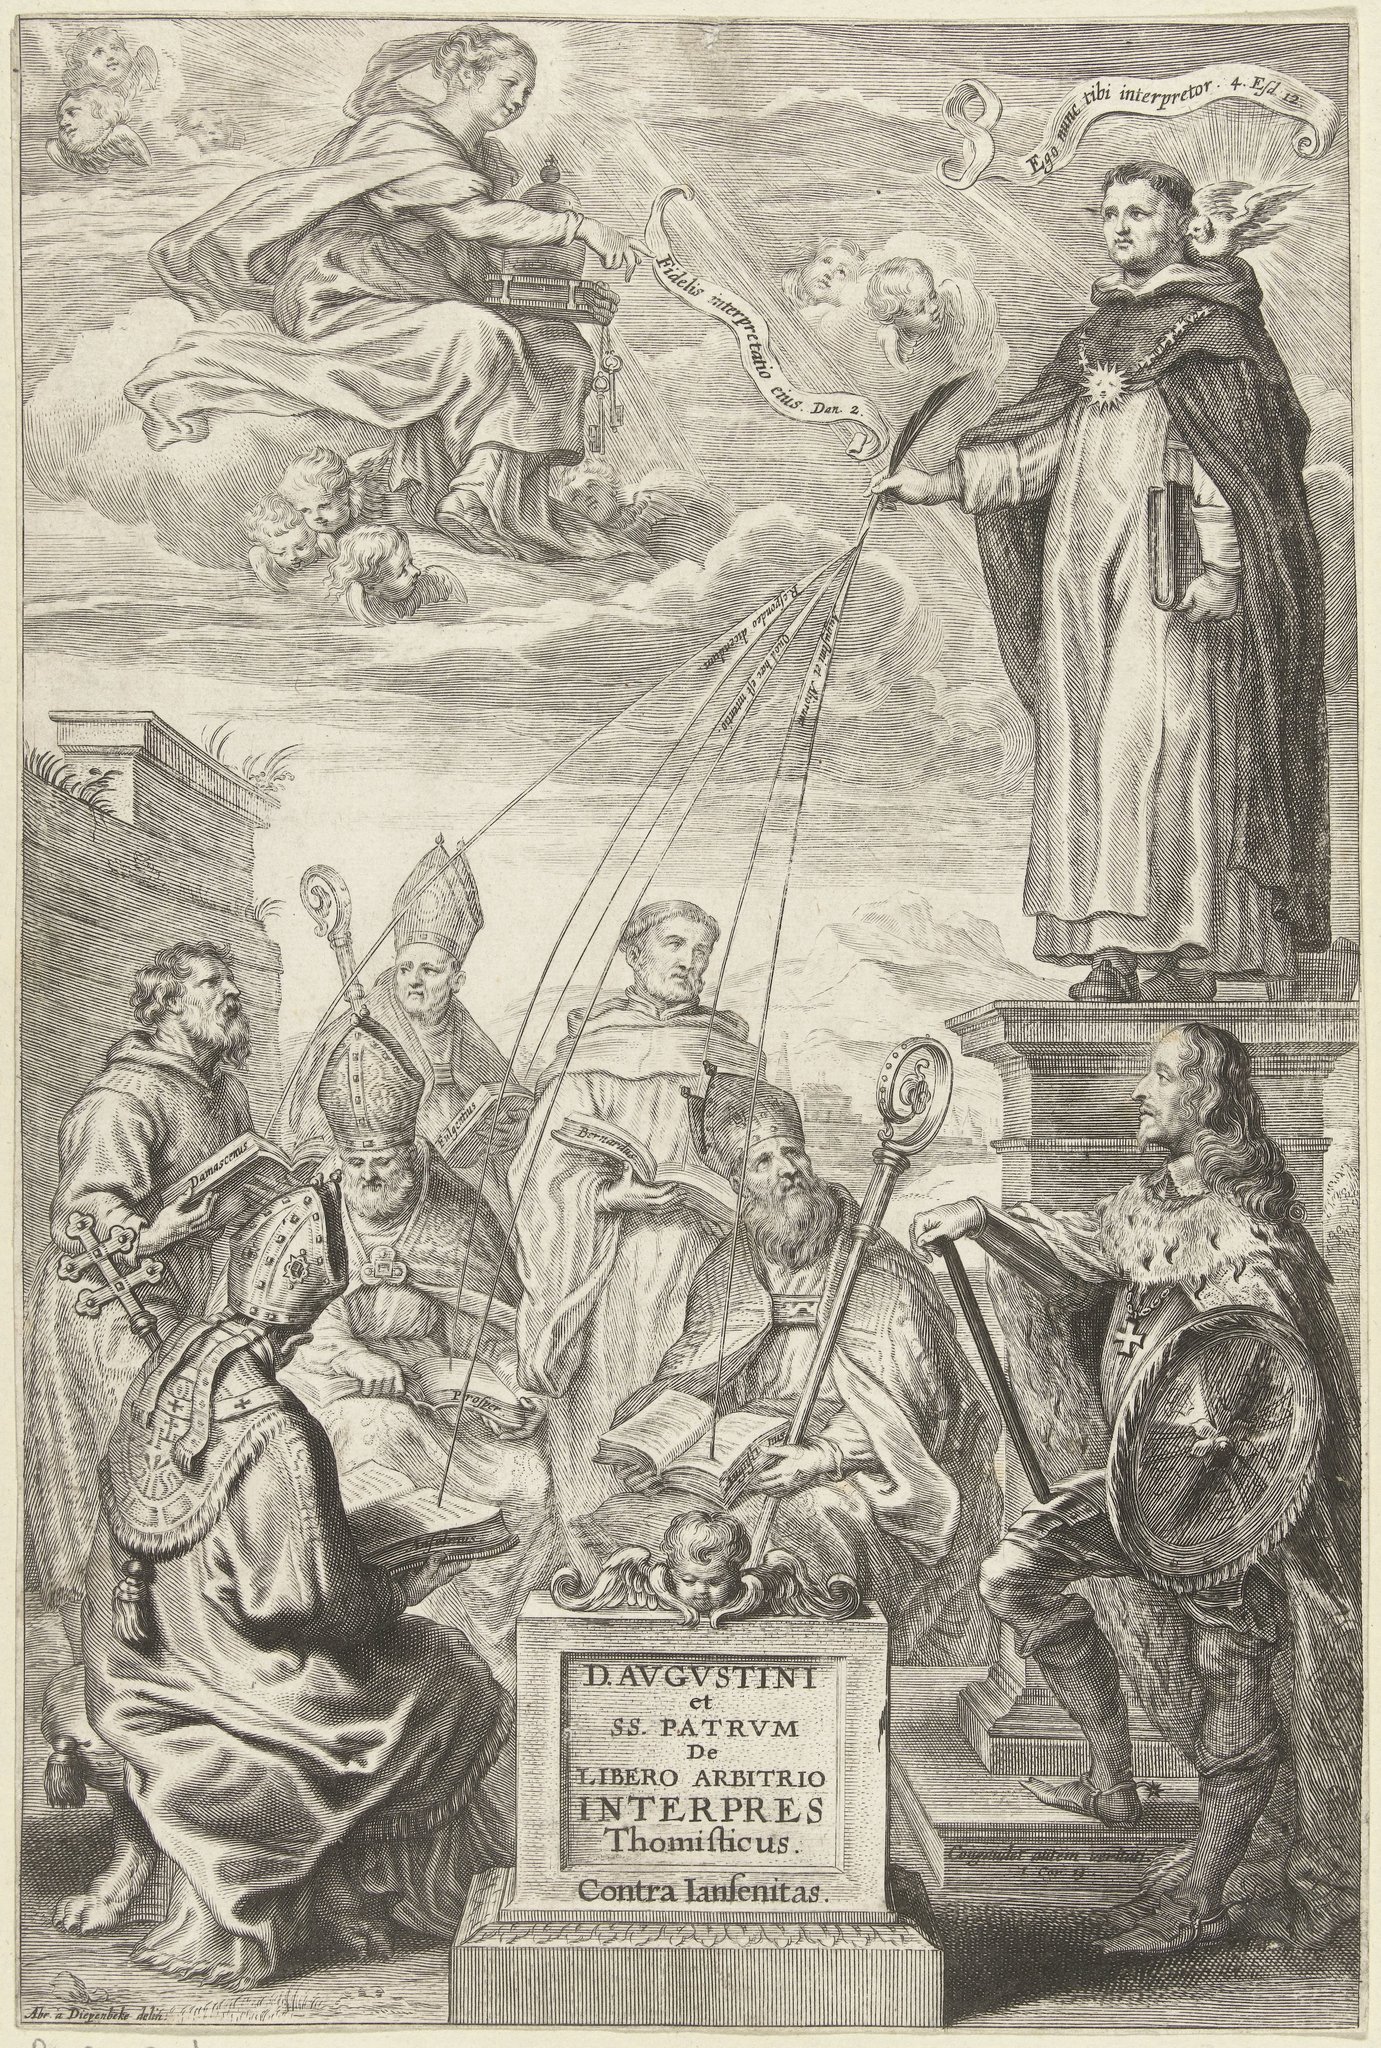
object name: print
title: Thomas van Aquino inspireert zich op de geschriften van andere theologen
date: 1652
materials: paper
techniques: engraving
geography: antwerp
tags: vienna, leopold willem van oostenrijk (landvoogd der zuidelijke nederlanden), augustine, bishop of hippo; possible attributes: arrows piercing his breast, book, child with spoon, flaming heart, heart (pierced with arrows), pen, bernard of clairvaux, cistercian monk and abbot; possible attributes: beehive, chained dragon, crucifix, cross with instruments of the passion, (three) mitre at his feet, white dog, madonna (i.e. mary with the christ-child) in the air, or on the clouds, the benedictine monk anselm, archbishop of canterbury; possible attributes: book, pen, ship, the dominican theologian, 'angelic doctor' thomas of aquino; possible attributes: book, (chain with) sun, dove, girdle of chastity, lily, model of church, monstrance (or chalice), mitre (under feet), star (on breast), male saints (with name)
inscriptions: collector's mark: Lugt 240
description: Thomas van Aquino staat op een sokkel. Hij heeft een ster op zijn borst en draagt een boek in de linkerhand. Een duif zit op zijn schouder en blaast Gods woord in zijn oor. In zijn linkerhand houdt hij een schrijfveer. Uit de schrijfveer leiden zes stralen naar zes verschillende Heiligen, wiens werken Thomas van Aquino geïnspireerd hebben: de Heilige Dacius van Damascus, de Heilige Anselmus, de Heilige Augustinus, de Heilige Bernardus, de Heilige Fulgentius en de Heilige Prosper. Boven in de wolken verschijnt Maria. Rechtsonder in de hoek Leopold Willem, landvoogd der Zuidelijke Nederlanden aan wie het boek is opgedragen.